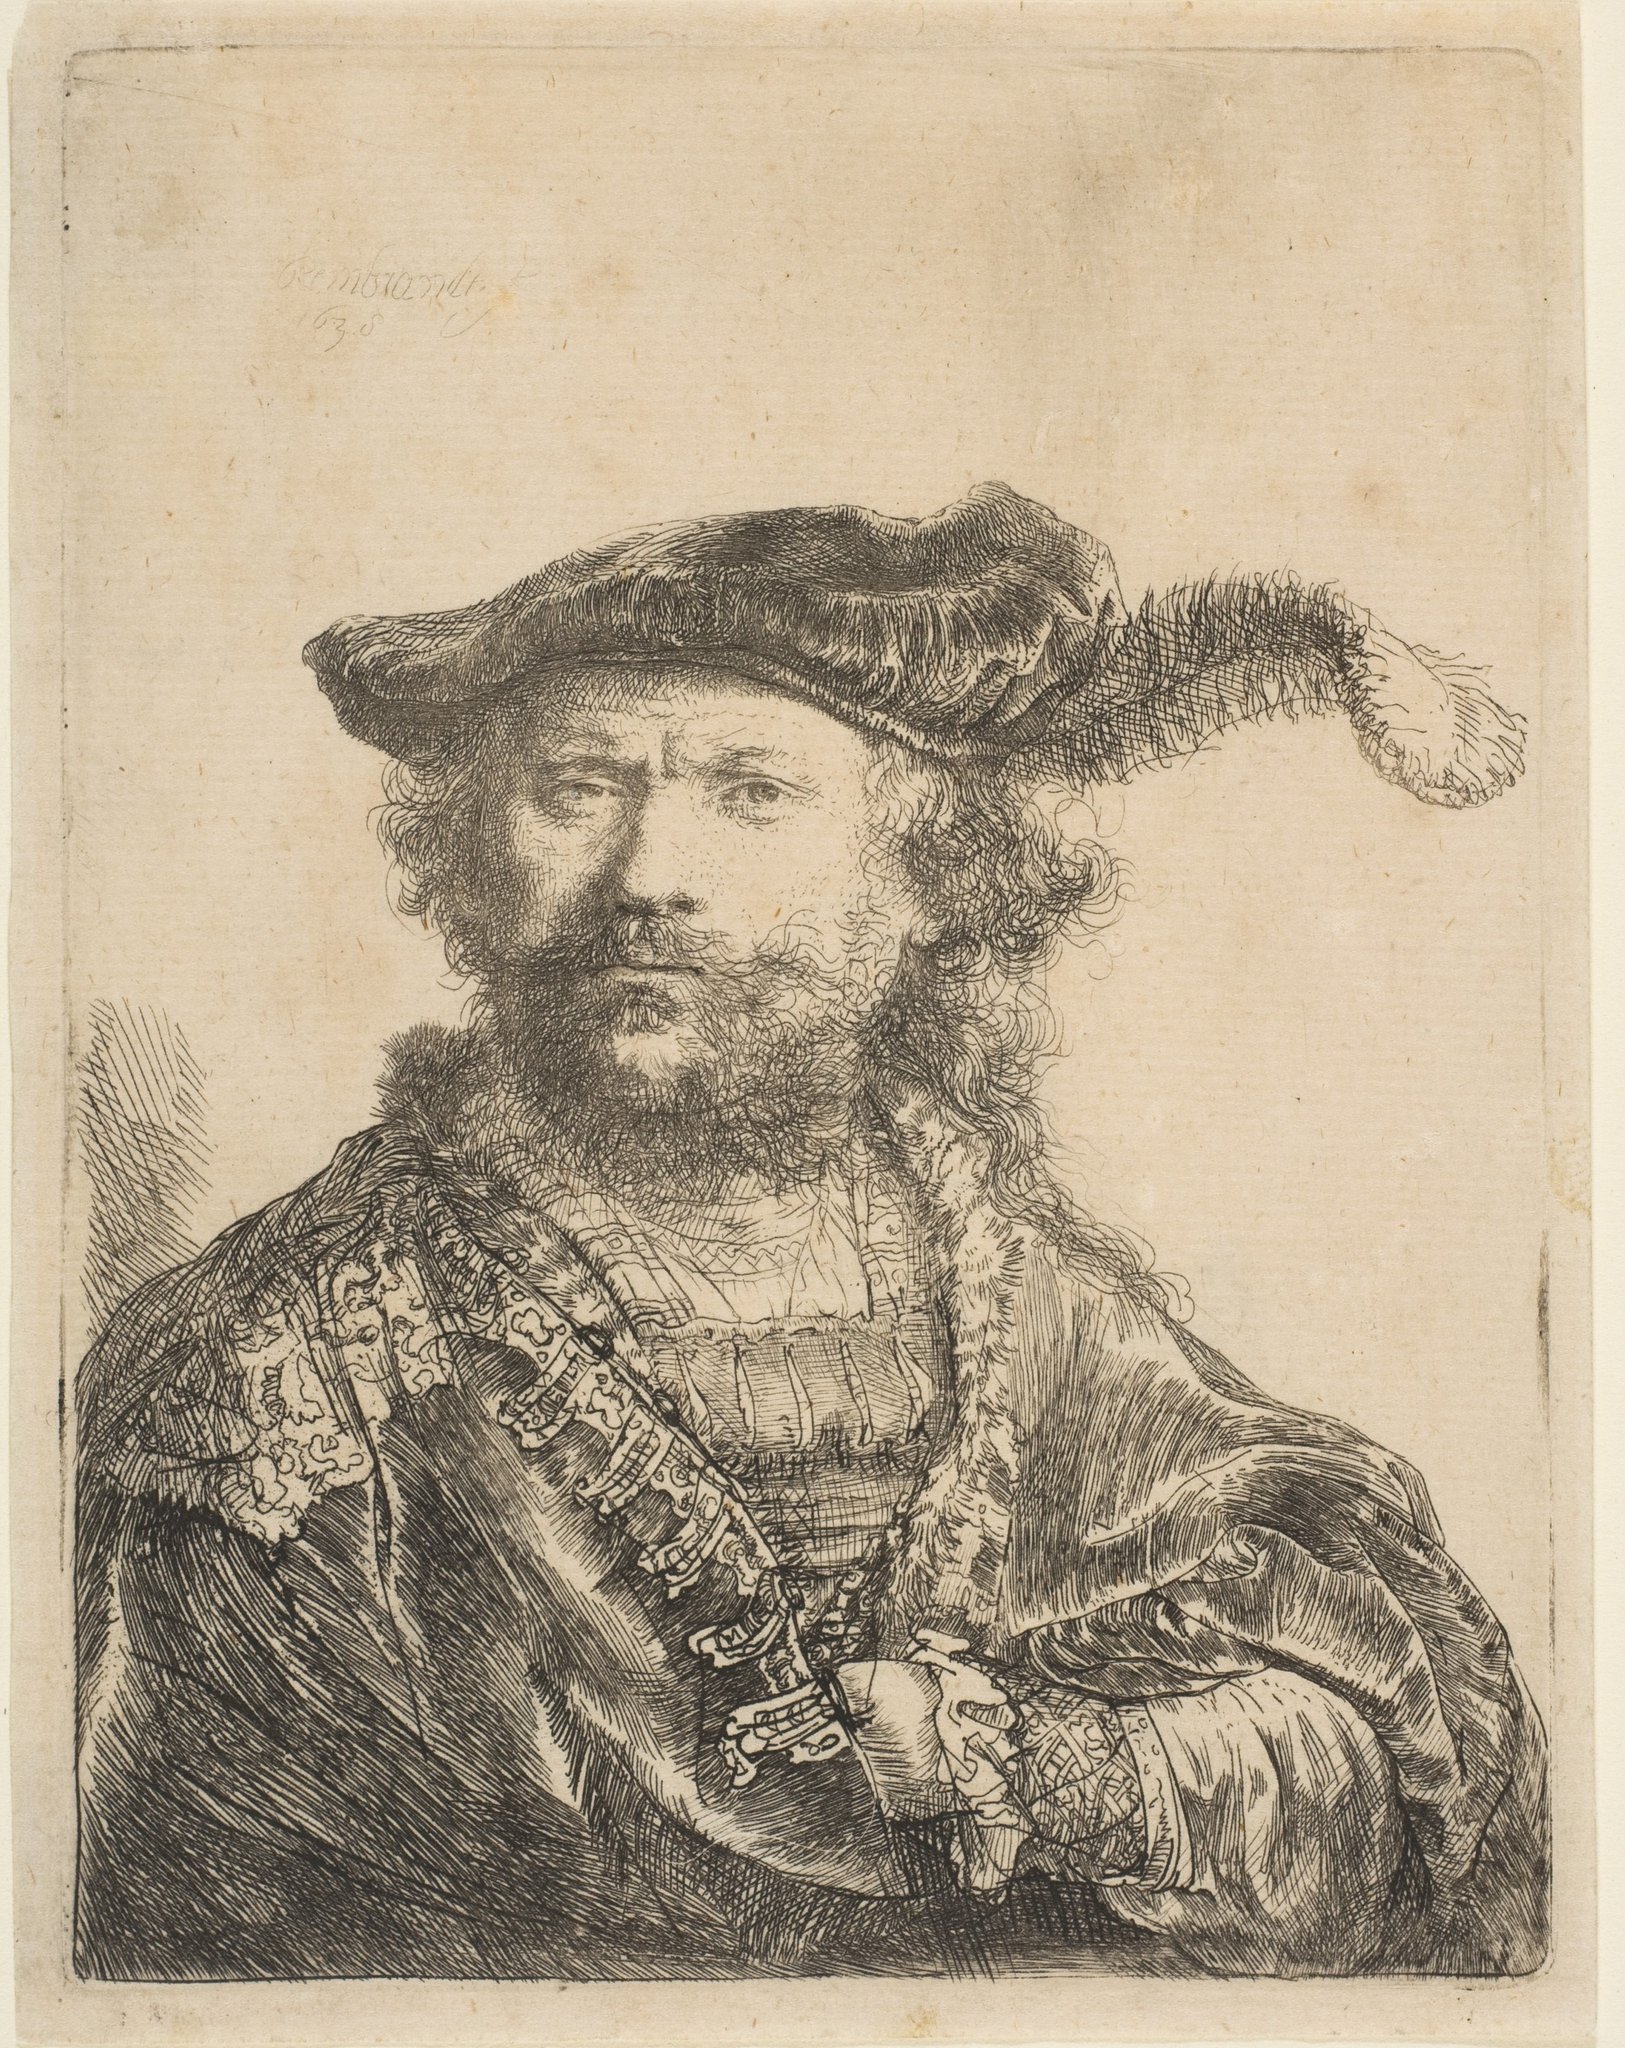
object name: print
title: Self-Portrait in a Velvet Cap with Plume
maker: rembrandt van rijn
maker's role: artist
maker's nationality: dutch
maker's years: 1606-1669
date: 1638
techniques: etching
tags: men,self-portraits